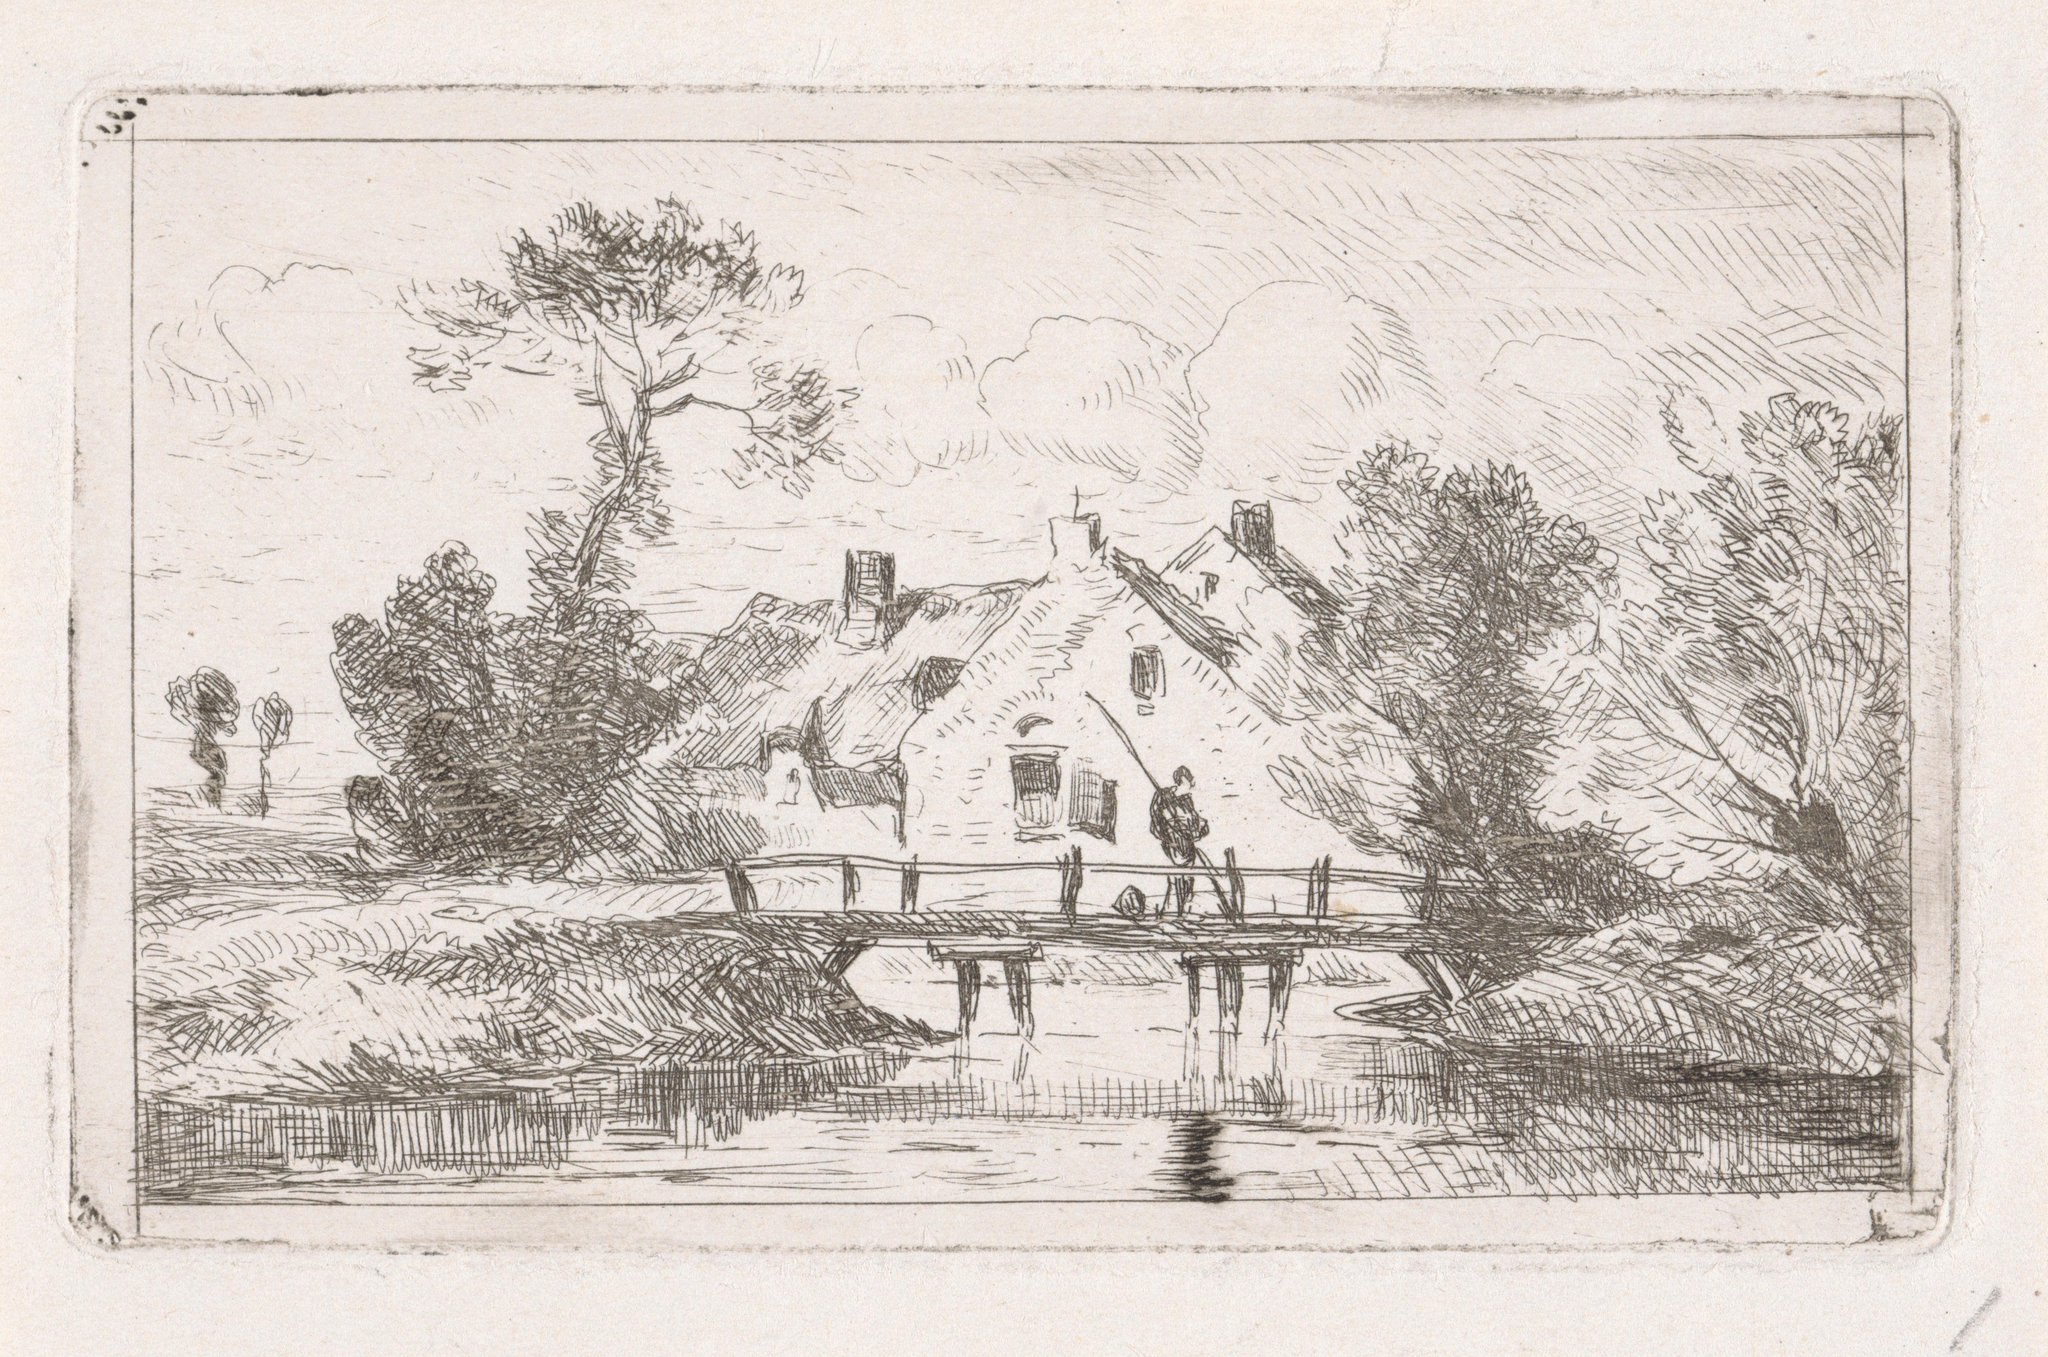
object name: print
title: Hengelaar op een bruggetje bij een boerderij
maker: jan gerard smits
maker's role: draughtsman, print maker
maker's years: 1823-1910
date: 1875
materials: paper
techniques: drypoint, etching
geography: the hague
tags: fisherman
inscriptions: collector's mark: Lugt 2228